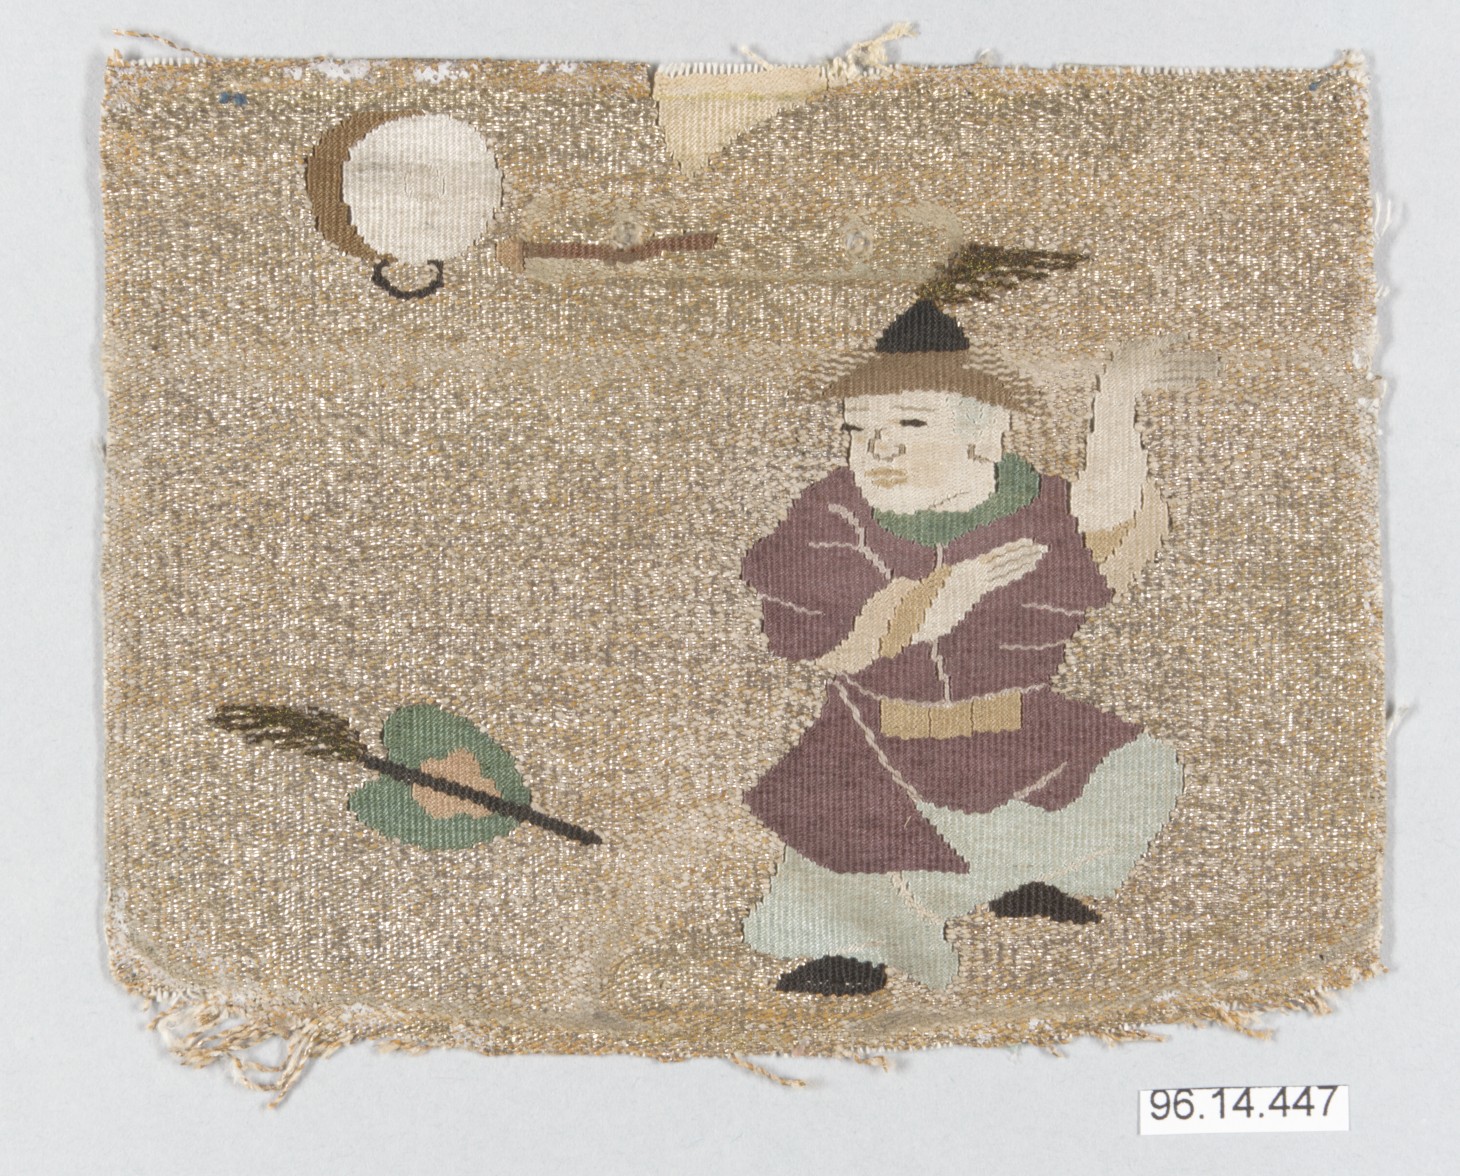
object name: piece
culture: japanese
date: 1701-1900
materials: silk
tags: fans,men,dancing,drums